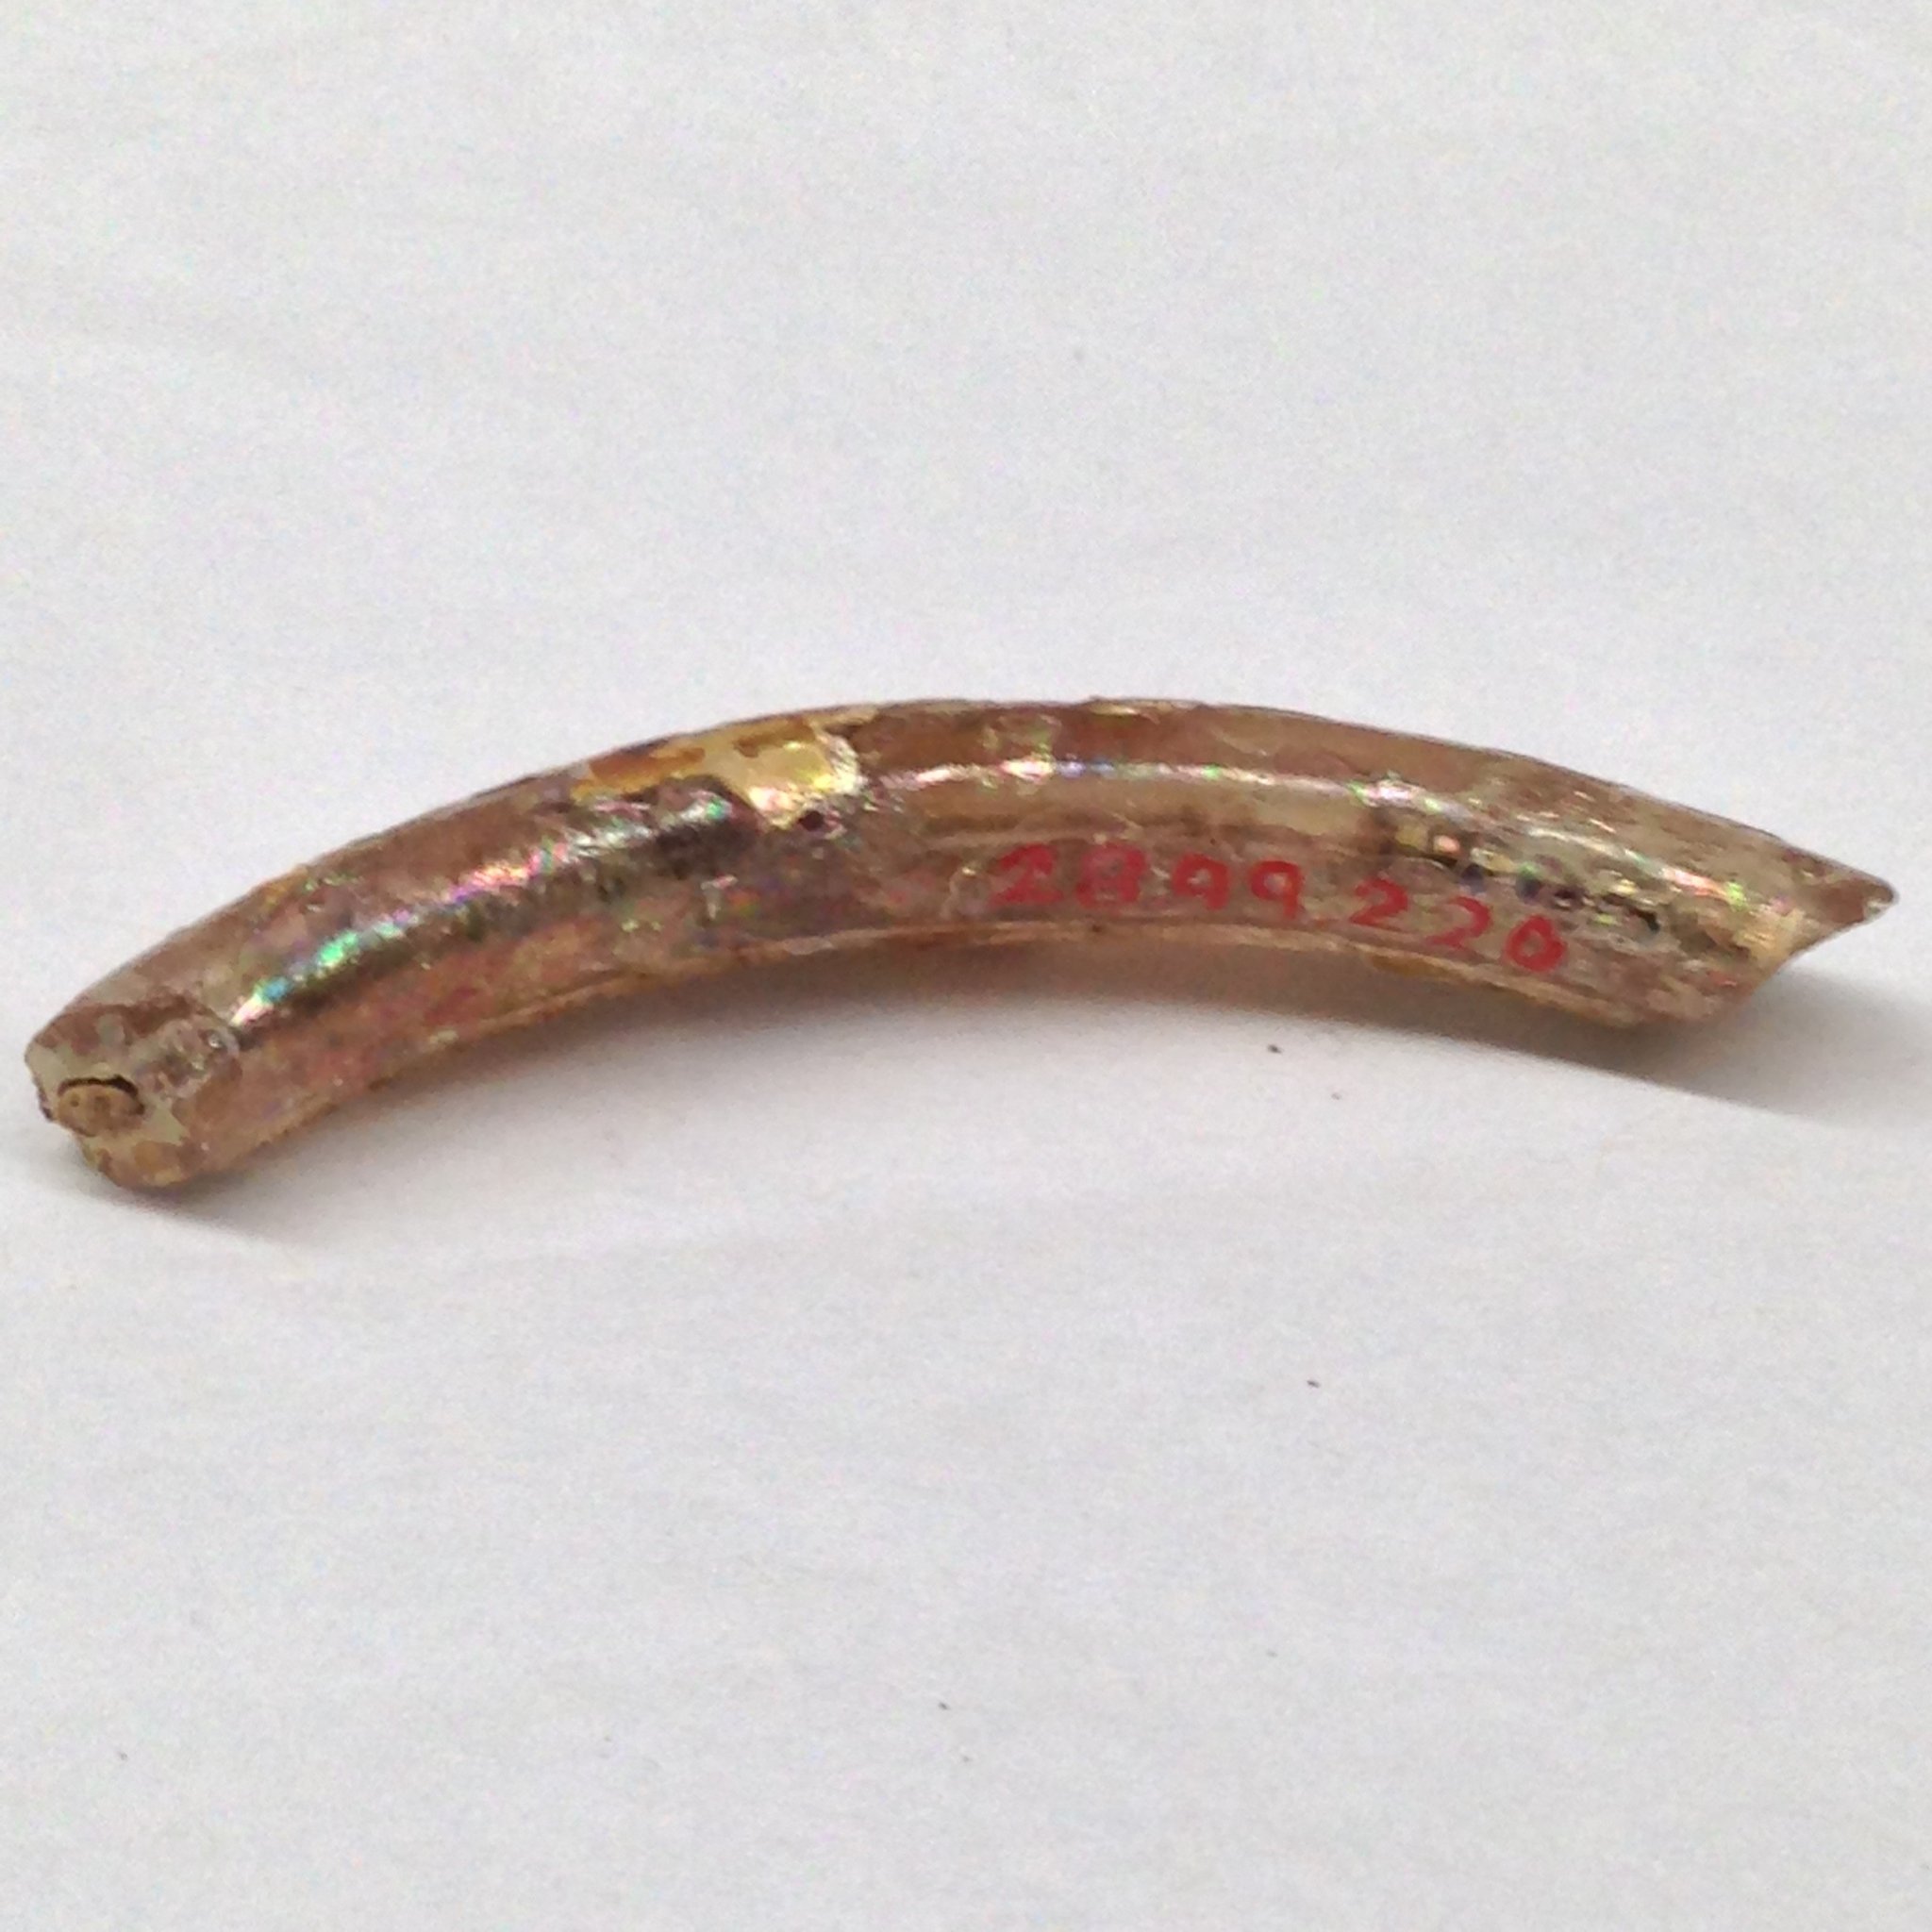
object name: fragment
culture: european or middle eastern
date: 1150-1250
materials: ceramic, glass